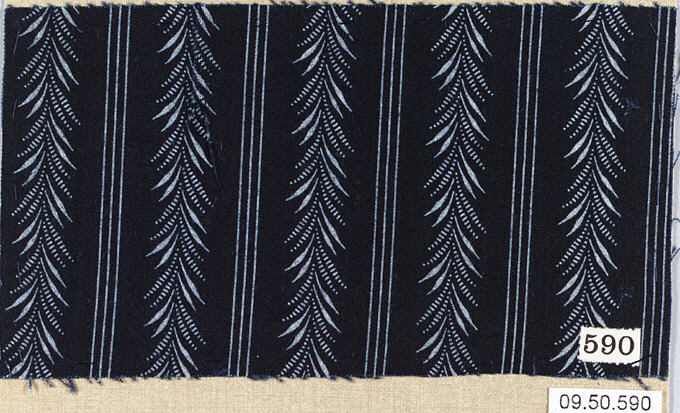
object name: piece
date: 1801-1900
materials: cotton